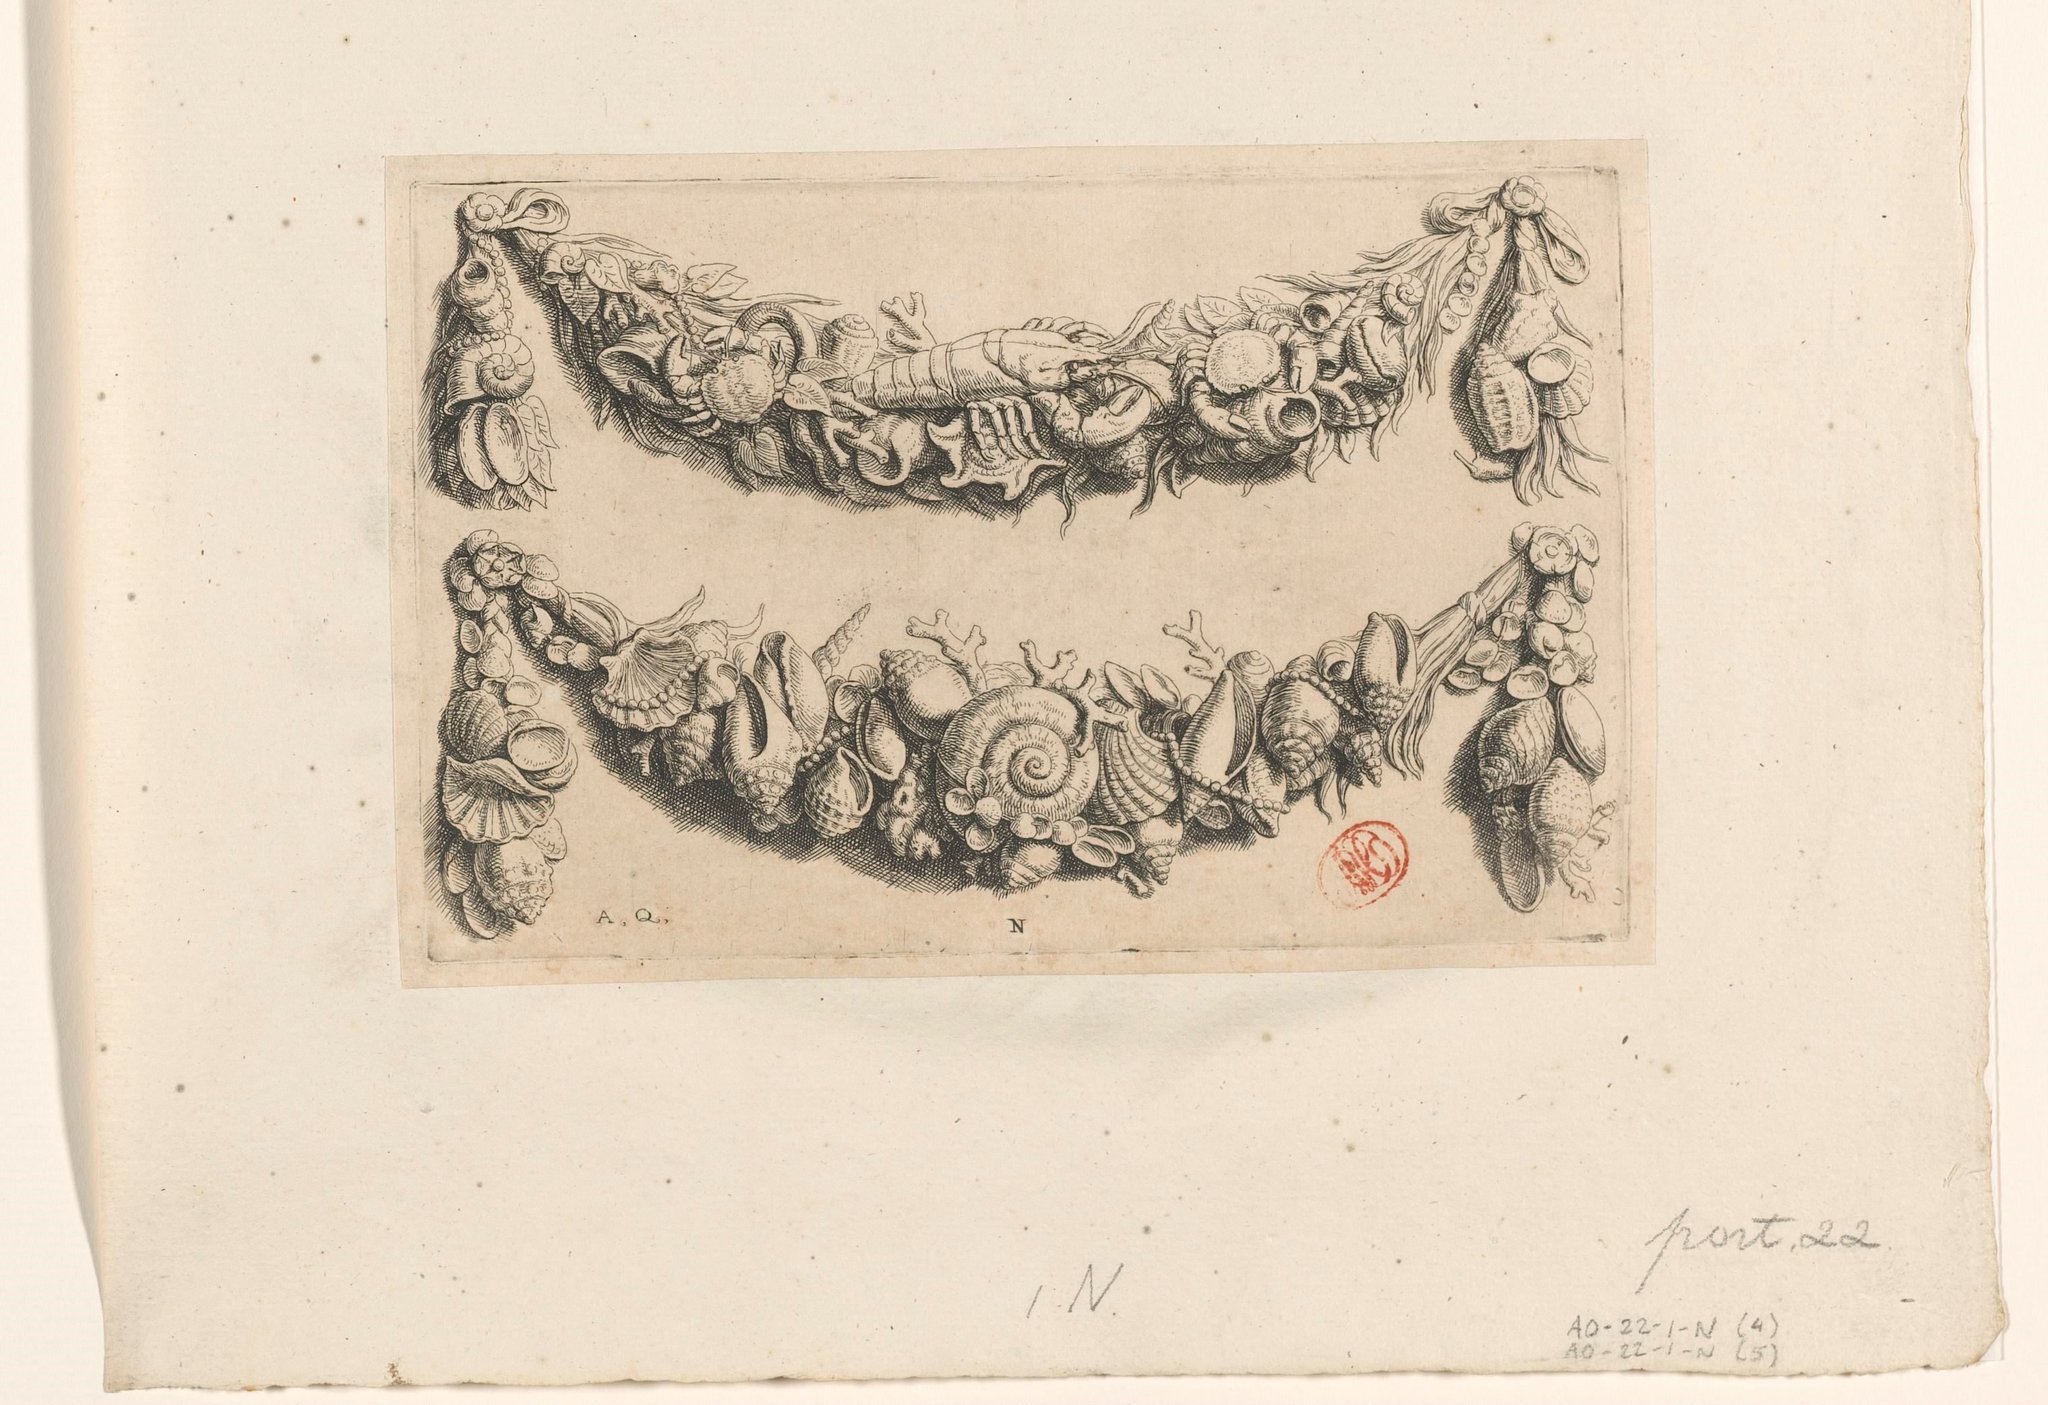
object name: book illustration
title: Twee festoenen met schaaldieren en schelpen in de oostelijke galerij van het Stadhuis op de Dam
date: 1655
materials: paper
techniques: engraving, etching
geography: amsterdam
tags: crustaceans, molluscs (+ shell, snail-shell etc.), ornament ~ festoon, garland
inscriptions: collector's mark: Lugt 195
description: Prent gebruikt in: Prima pars. Praecipuarum effigierum ac ornamentorum, amplissimae Curiae Amstelrodamensis (…) / Het eerste deel. Van de voornaemste Statuen ende Ciraten, vant konstijck Stadhuys van Amstelredam, tmeeste in marmer gemaeckt, door Artus Quellinus, Beelthouwer der voorseyde Stadt / La Premier Partie. De plusieurs Figures et ornements, de la Maison de Ville d'Amsterdam (…). Amsterdam: Artus Quellinus (I), 1655. Zie RP-P-AO-22-1-1 voor bijhorende titelpagina. Zie RP-P-AO-22-1-2 voor bijhorend register. Zie RP-P-AO-22-1A, RP-P-AO-22-1B, RP-P-AO-22-1C, RP-P-AO-22-1D-1, RP-P-AO-22-1D-2, RP-P-AO-22-1E, RP-P-AO-22-1F, RP-P-AO-22-1G, RP-P-AO-22-1H, RP-P-AO-22-1I, RP-P-AO-22-1K-1, RP-P-AO-22-1K-2, RP-P-AO-22-1K-3, RP-P-AO-22-1K-4, RP-P-AO-22-1K-5, RP-P-AO-22-1L-1, RP-P-AO-22-1L-2, RP-P-AO-22-1M-1, RP-P-AO-22-1M-2, RP-P-AO-22-1N-1, RP-P-AO-22-1N-2, RP-P-AO-22-1N-3, RP-P-AO-22-1N-4, RP-P-AO-22-1O-1, RP-P-AO-22-1O-2, RP-P-AO-22-1O-3, RP-P-AO-22-1O-4, RP-P-AO-22-1P-1, RP-P-AO-22-1P-2, RP-P-AO-22-1P-3, RP-P-AO-22-1P-4, RP-P-AO-22-1Q-1, RP-P-AO-22-1Q-2, RP-P-AO-22-1Q-3, RP-P-AO-22-1Q-4, RP-P-AO-22-1R-1, RP-P-AO-22-1R-2, RP-P-AO-22-1R-3, RP-P-AO-22-1R-4, RP-P-AO-22-1R-5, RP-P-AO-22-1S-1, RP-P-AO-22-1S-2, RP-P-AO-22-1S-3, RP-P-AO-22-1S-4, RP-P-AO-22-1S-5, RP-P-AO-22-1T-1 en RP-P-AO-22-1T-2 voor andere prenten uit deze publicatie. Zelfde staat van prent ook gebruikt in: Prima pars. Praecipuarum effigierum ac ornamentorum, amplissimae Curiae Amstelrodamensis (…) / Het eerste deel. Van de voornaemste Statuen ende Ciraten, vant konstijck Stadhuys van Amstelredam, tmeeste in marmer gemaeckt, door Artus Quellinus, Beelthouwer der voorseyde Stadt / La Premier Partie. De plusieurs Figures et ornements, de la Maison de Ville d'Amsterdam (…). Amsterdam: Frederik de Wit, 1665. Latere staat van prent ook gebruikt in: Architecture peinture et sculpture de la Maison de Ville d'Amsterdam, representee en CIX. figures en taille-douce (…). Amsterdam: David Mortier, 1719. En in: Architecture peinture et sculpture de la Maison de Ville d'Amsterdam, representee en CIX. figures en taille-douce (…). Amsterdam: Gerard Valck, 1719. En in: Bouw schilder en beeldhouwkonst, van het Stadhuis te Amsteldam, vertoont in CIX figuuren (…). Amsterdam: Covens & Mortier & Covens Jr., s.a. (1774-1783).